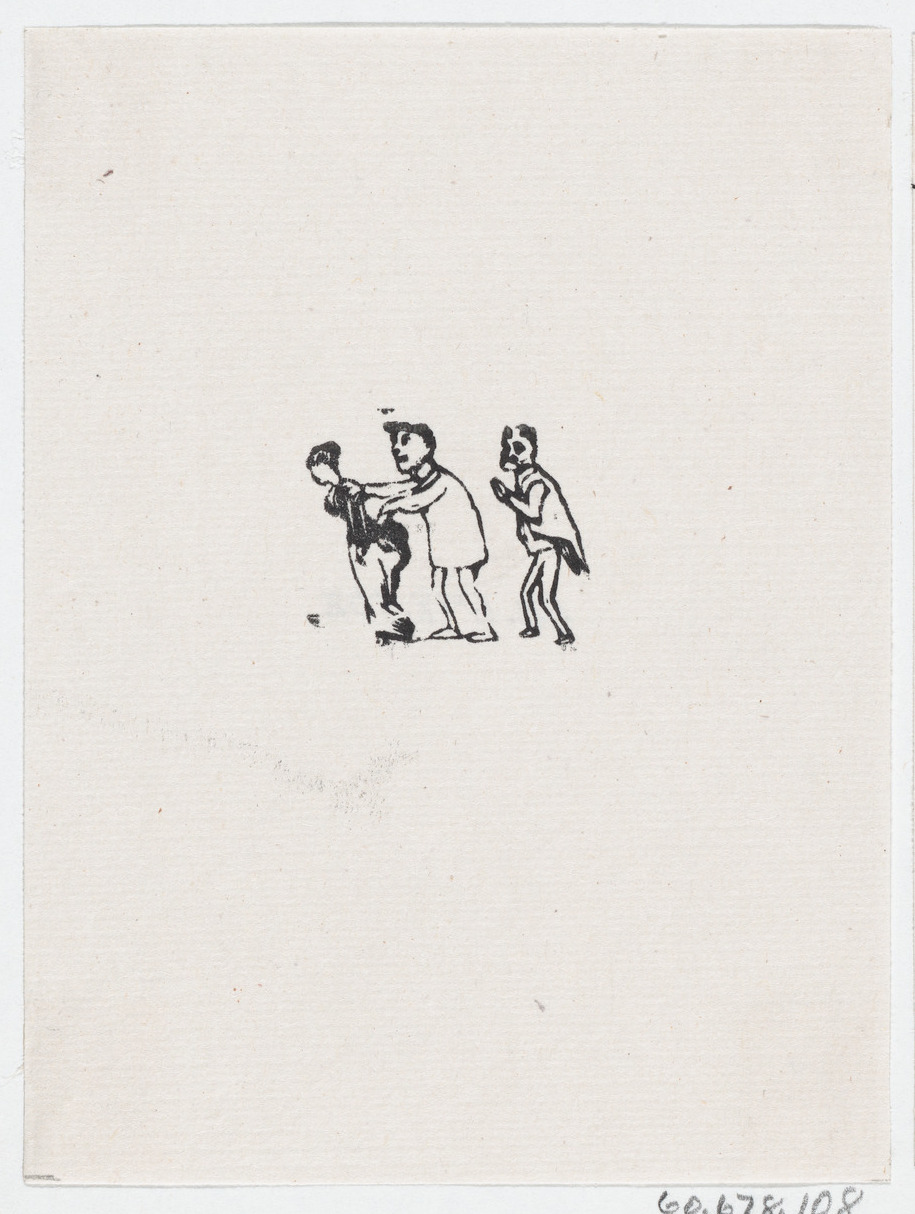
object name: print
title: Three figures walking in a line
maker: josé guadalupe posada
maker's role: artist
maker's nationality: mexican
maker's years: 1852-1913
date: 1880-1910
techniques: lithography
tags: men,women,walking